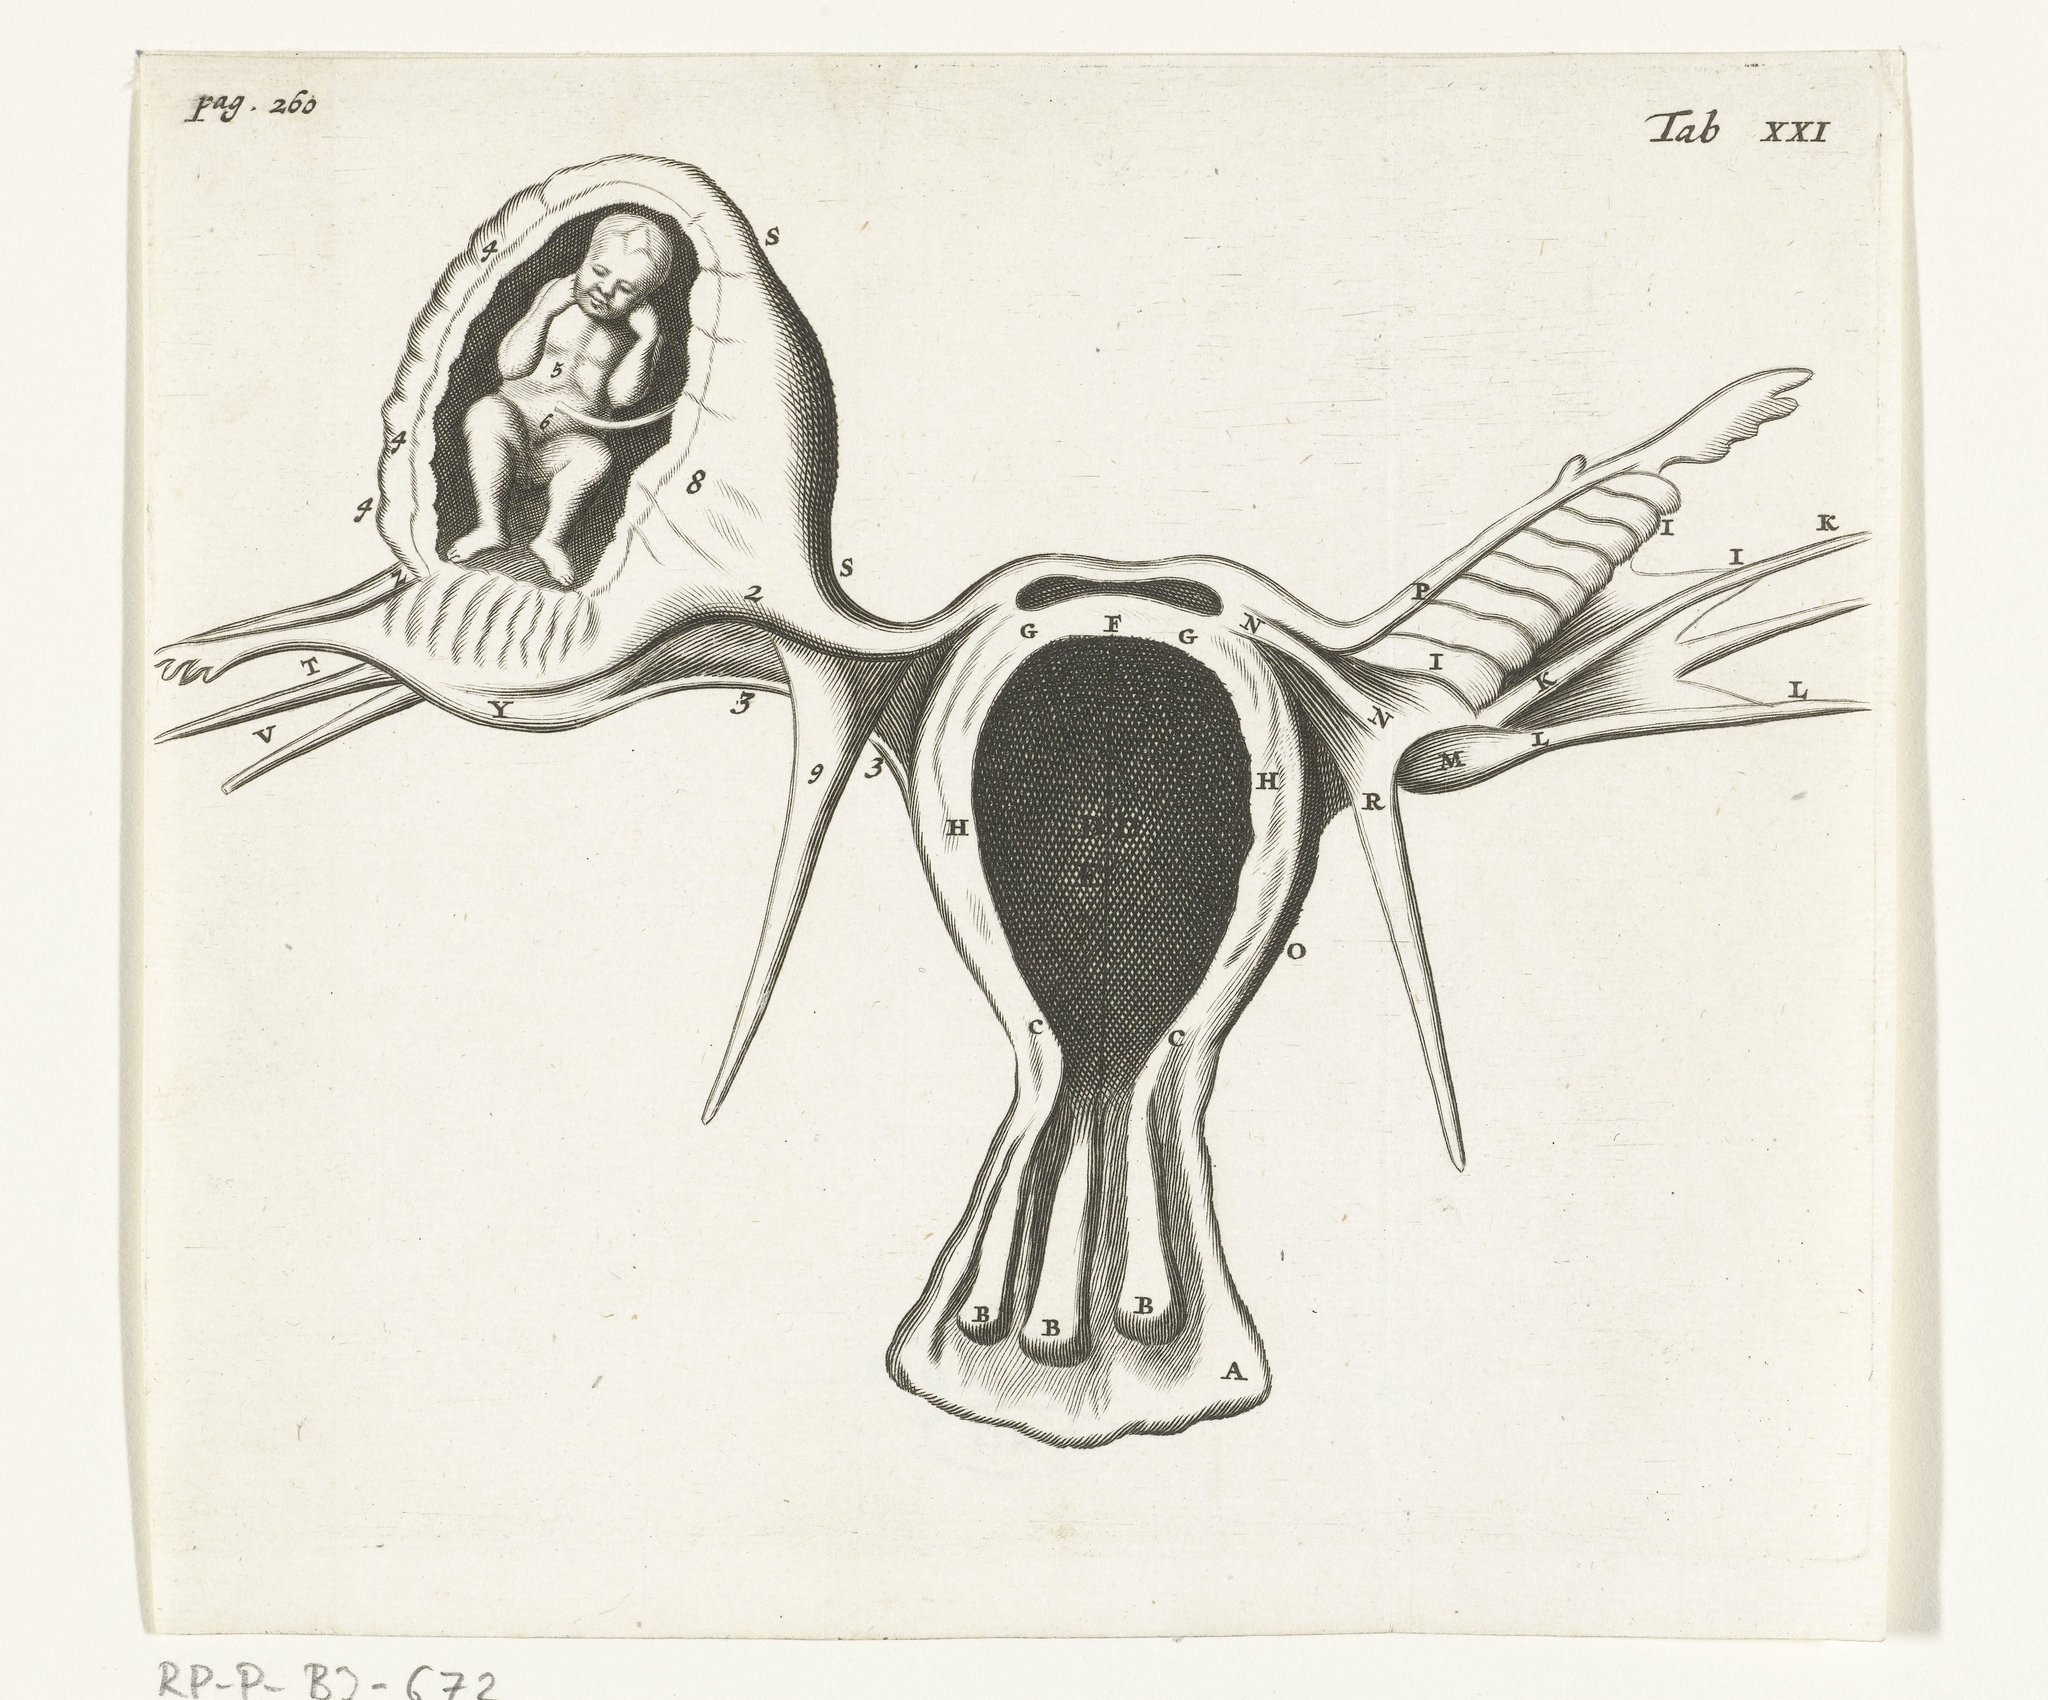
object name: book illustration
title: Anatomical depiction of an ectopic pregnancy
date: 1672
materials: paper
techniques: engraving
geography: netherlands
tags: uterus with foetus, pregnancy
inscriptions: collector's mark: Lugt 2228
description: In 1672 physician and anatomist Reinier de Graaf published De mulierum organis, a book about the organs of the female body, with prints by Hendrik Bary. De Graaf was the first to conclude that a foetus grows from the mother’s egg cell after it is fertilised by the father’s seed. He also discusses anomalies such as ectopic pregnancies (when the fertilised egg implants outside the womb).